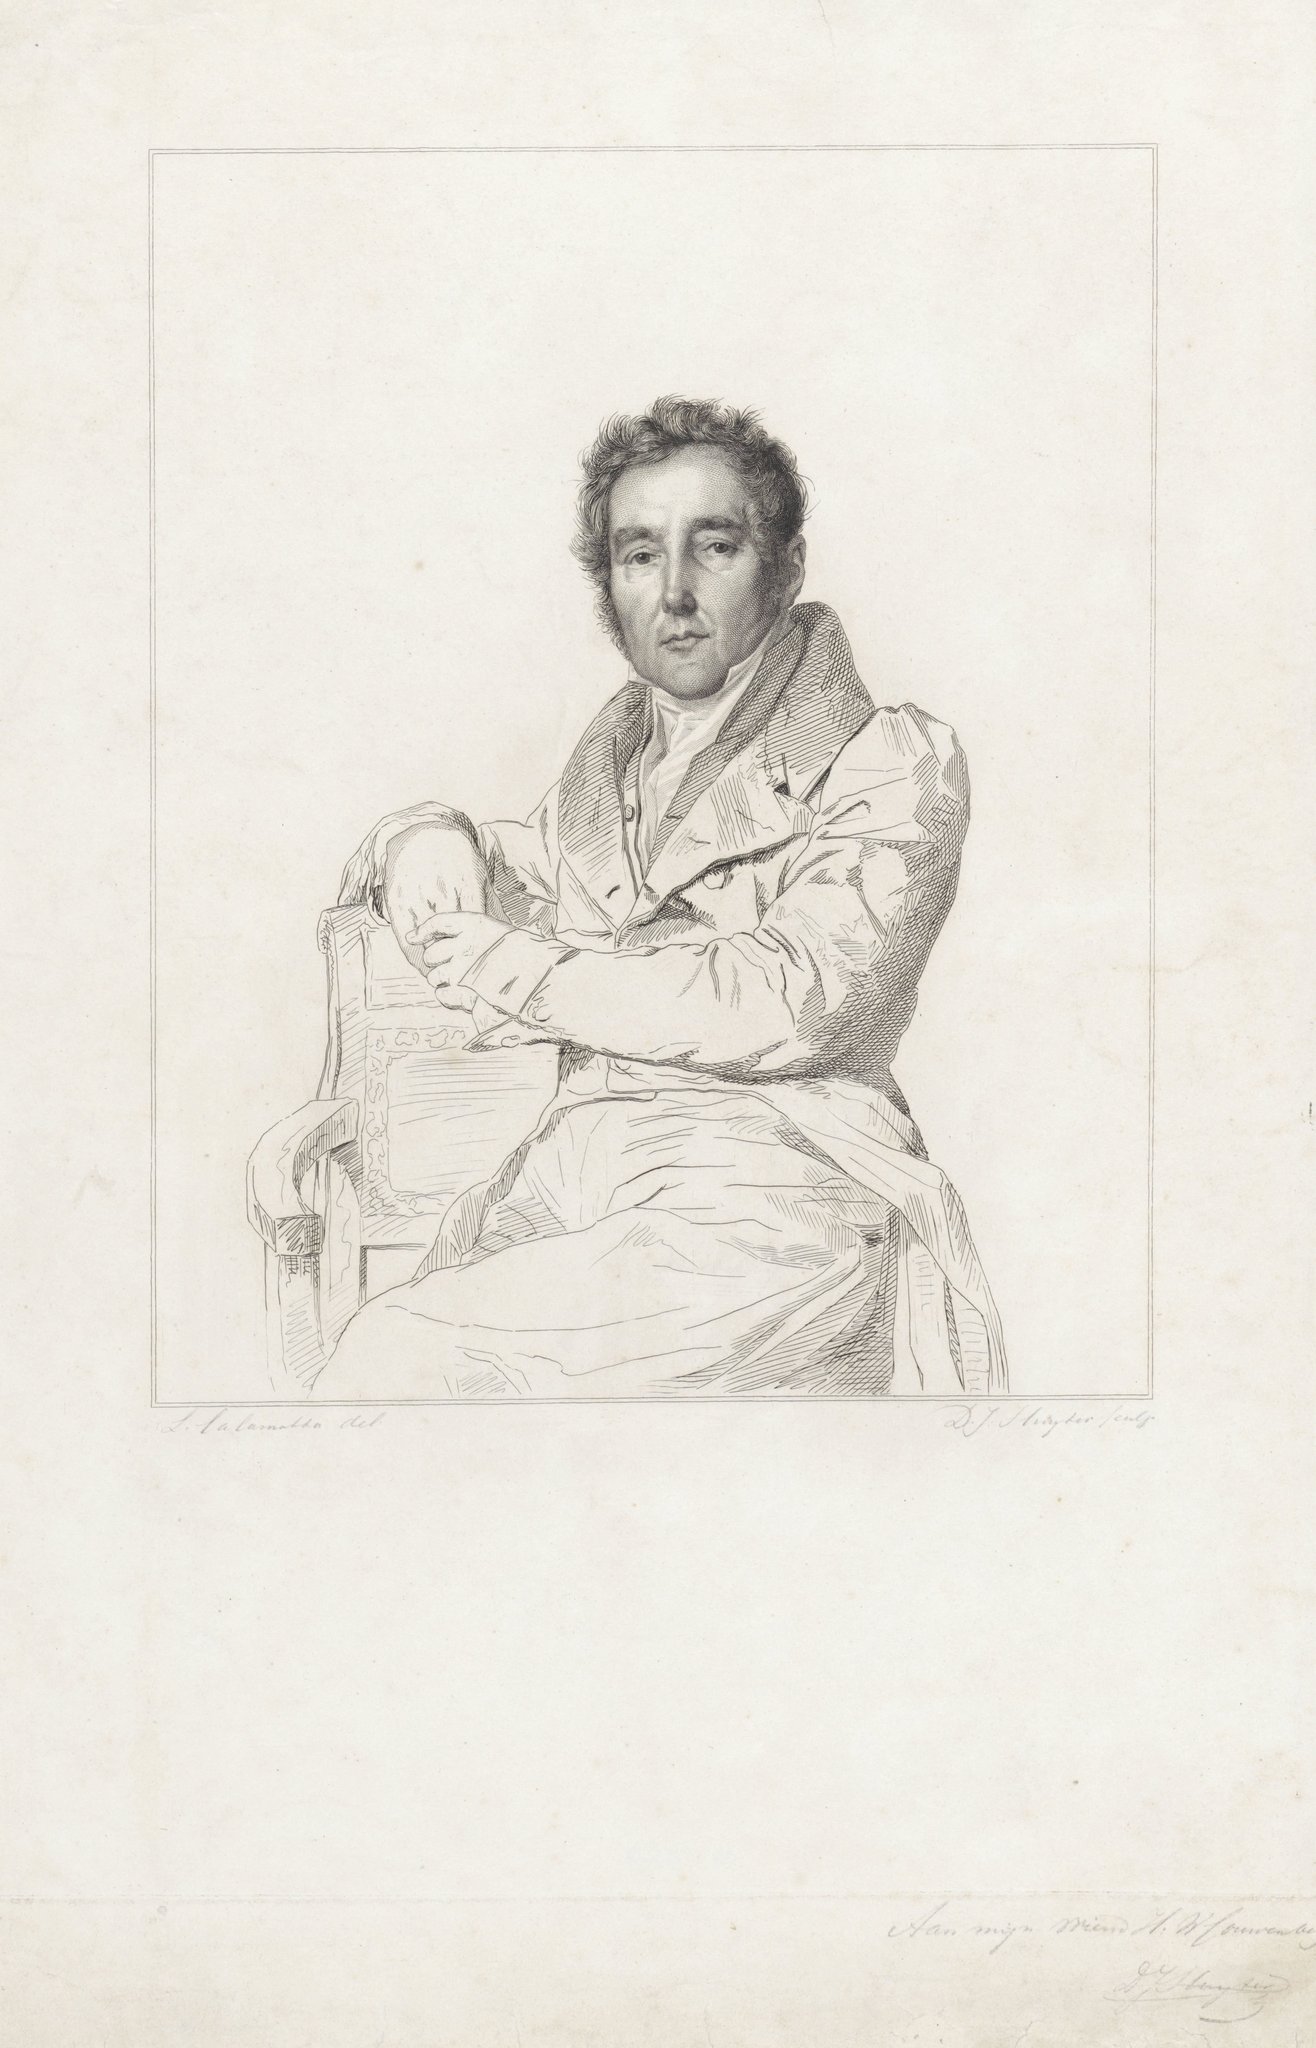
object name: print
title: Portret van Jacob de Vos Willemsz op 57-jarige leeftijd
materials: paper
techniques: etching, engraving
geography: amsterdam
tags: draughtsman, jacob willemz. de vos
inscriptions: inscription: ‘L. Calamatta del. - D.J. Sluyter sculp.’, inscription: ‘Aan mijn vriend H.W. Couwenberg - D.J. Sluyter’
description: Portret van de dichter en tekenaar Jacob de Vos Willemsz, nonchalant zittend op een stoel.